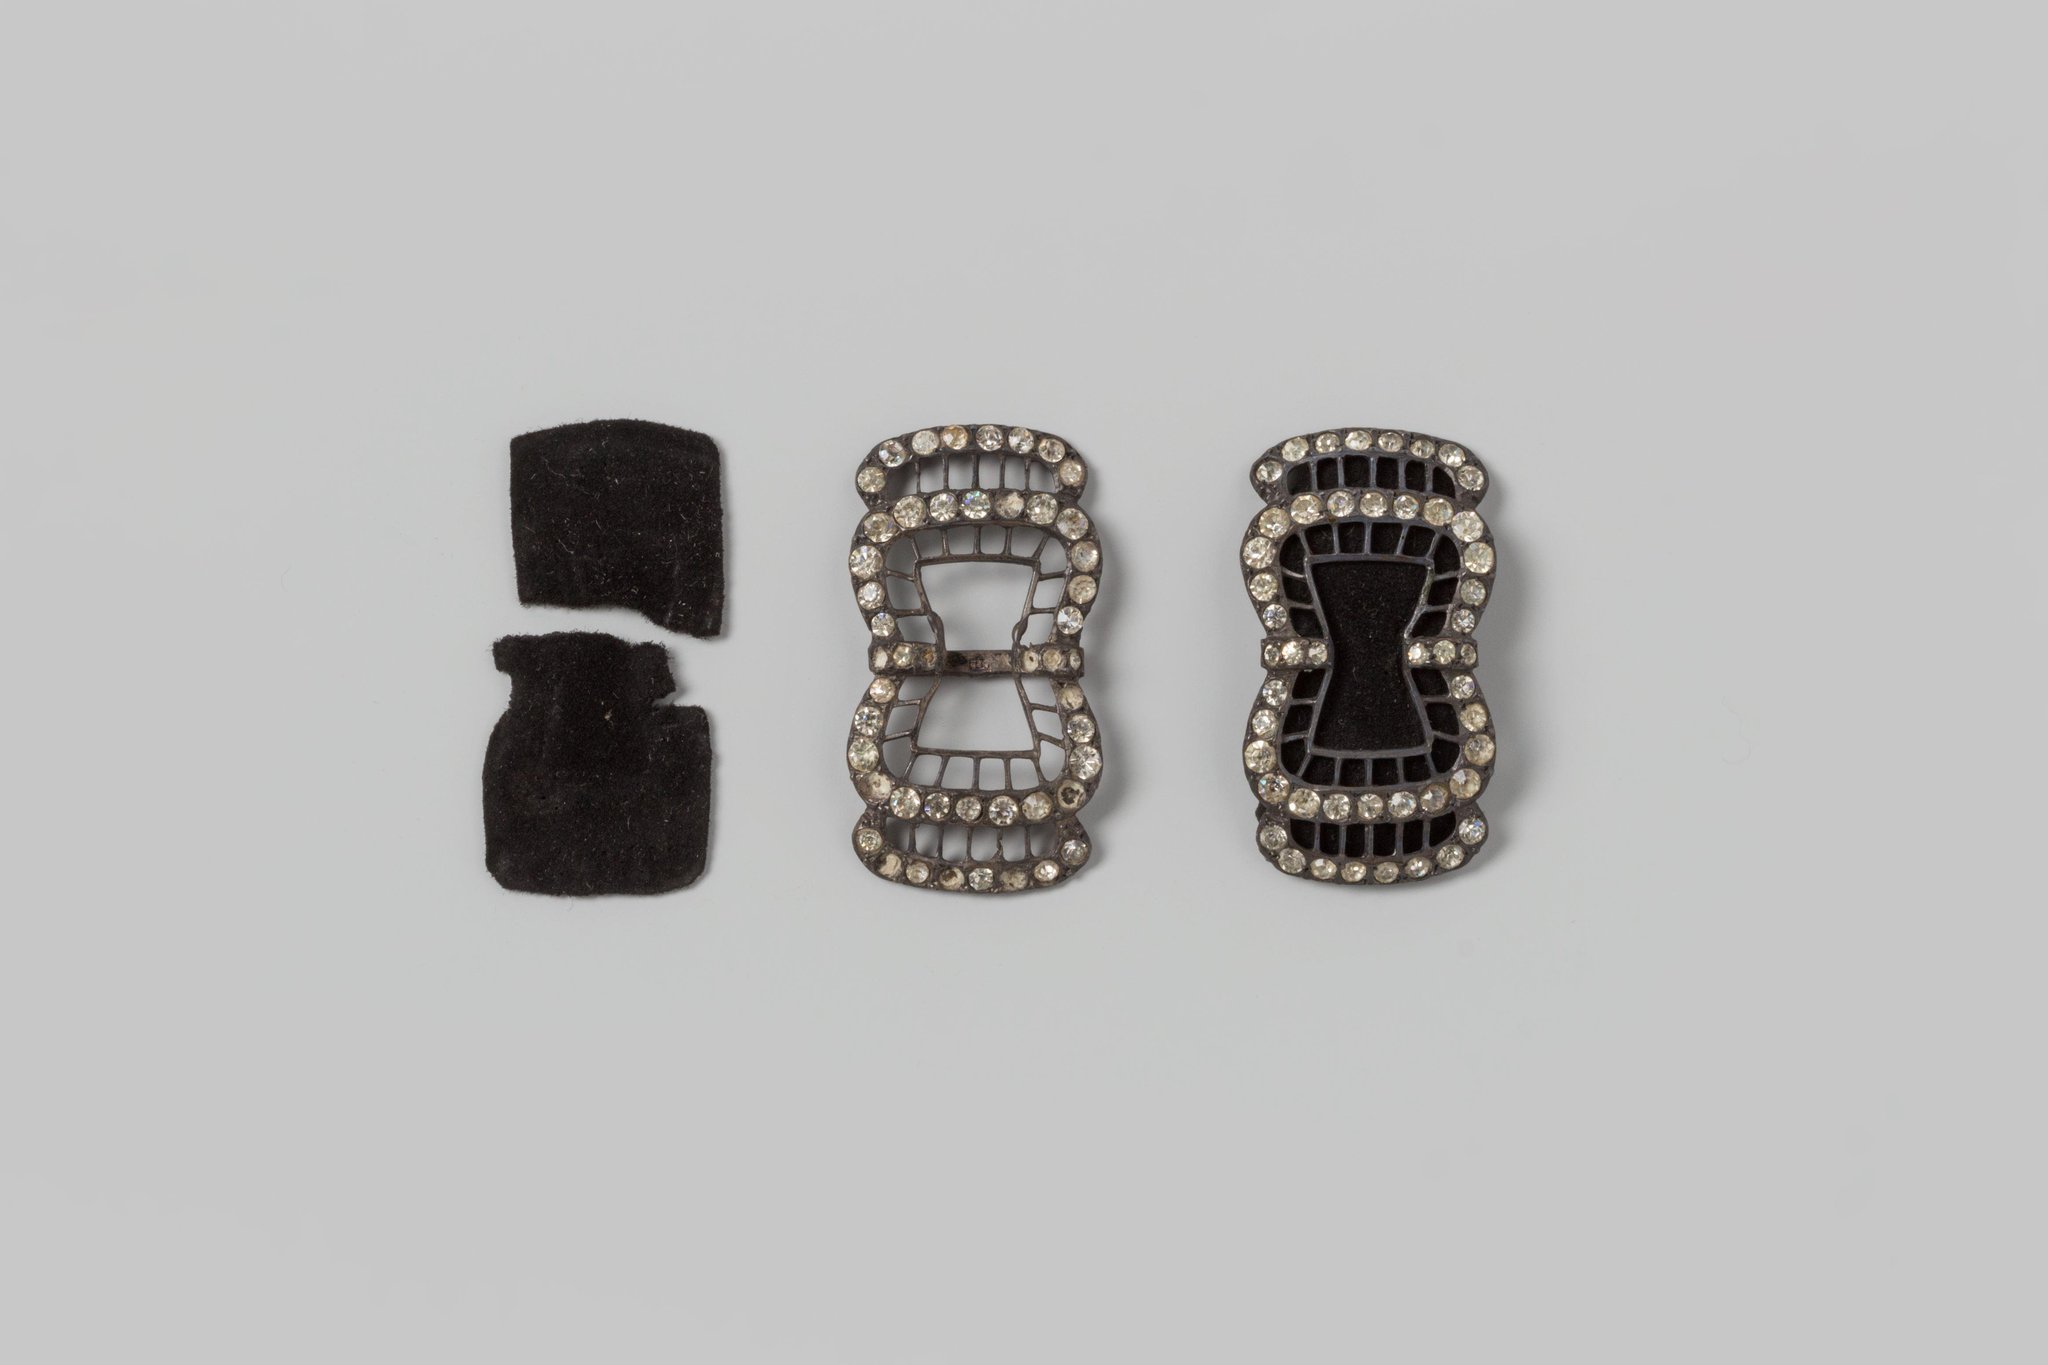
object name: jewellery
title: Schoengesp van zilver en stras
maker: p.j. klein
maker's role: jeweler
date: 1820-1830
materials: paste, silver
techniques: inlay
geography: sint-truiden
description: Schoengesp van zilver en stras. Strikmodel, in twee lagen concentrisch verdubbeld van zilver, ingelegd met rijen stras.